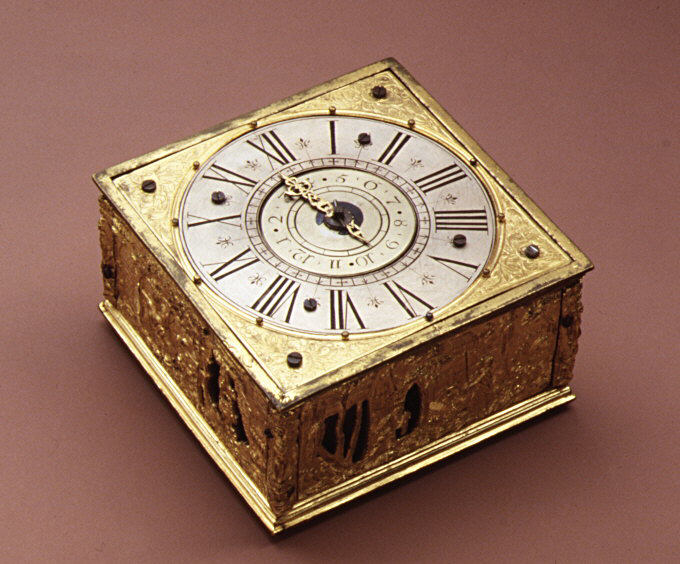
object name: table clock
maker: johann reinhold the elder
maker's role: maker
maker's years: 1550-1596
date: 1567-1600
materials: brass, gilt, iron